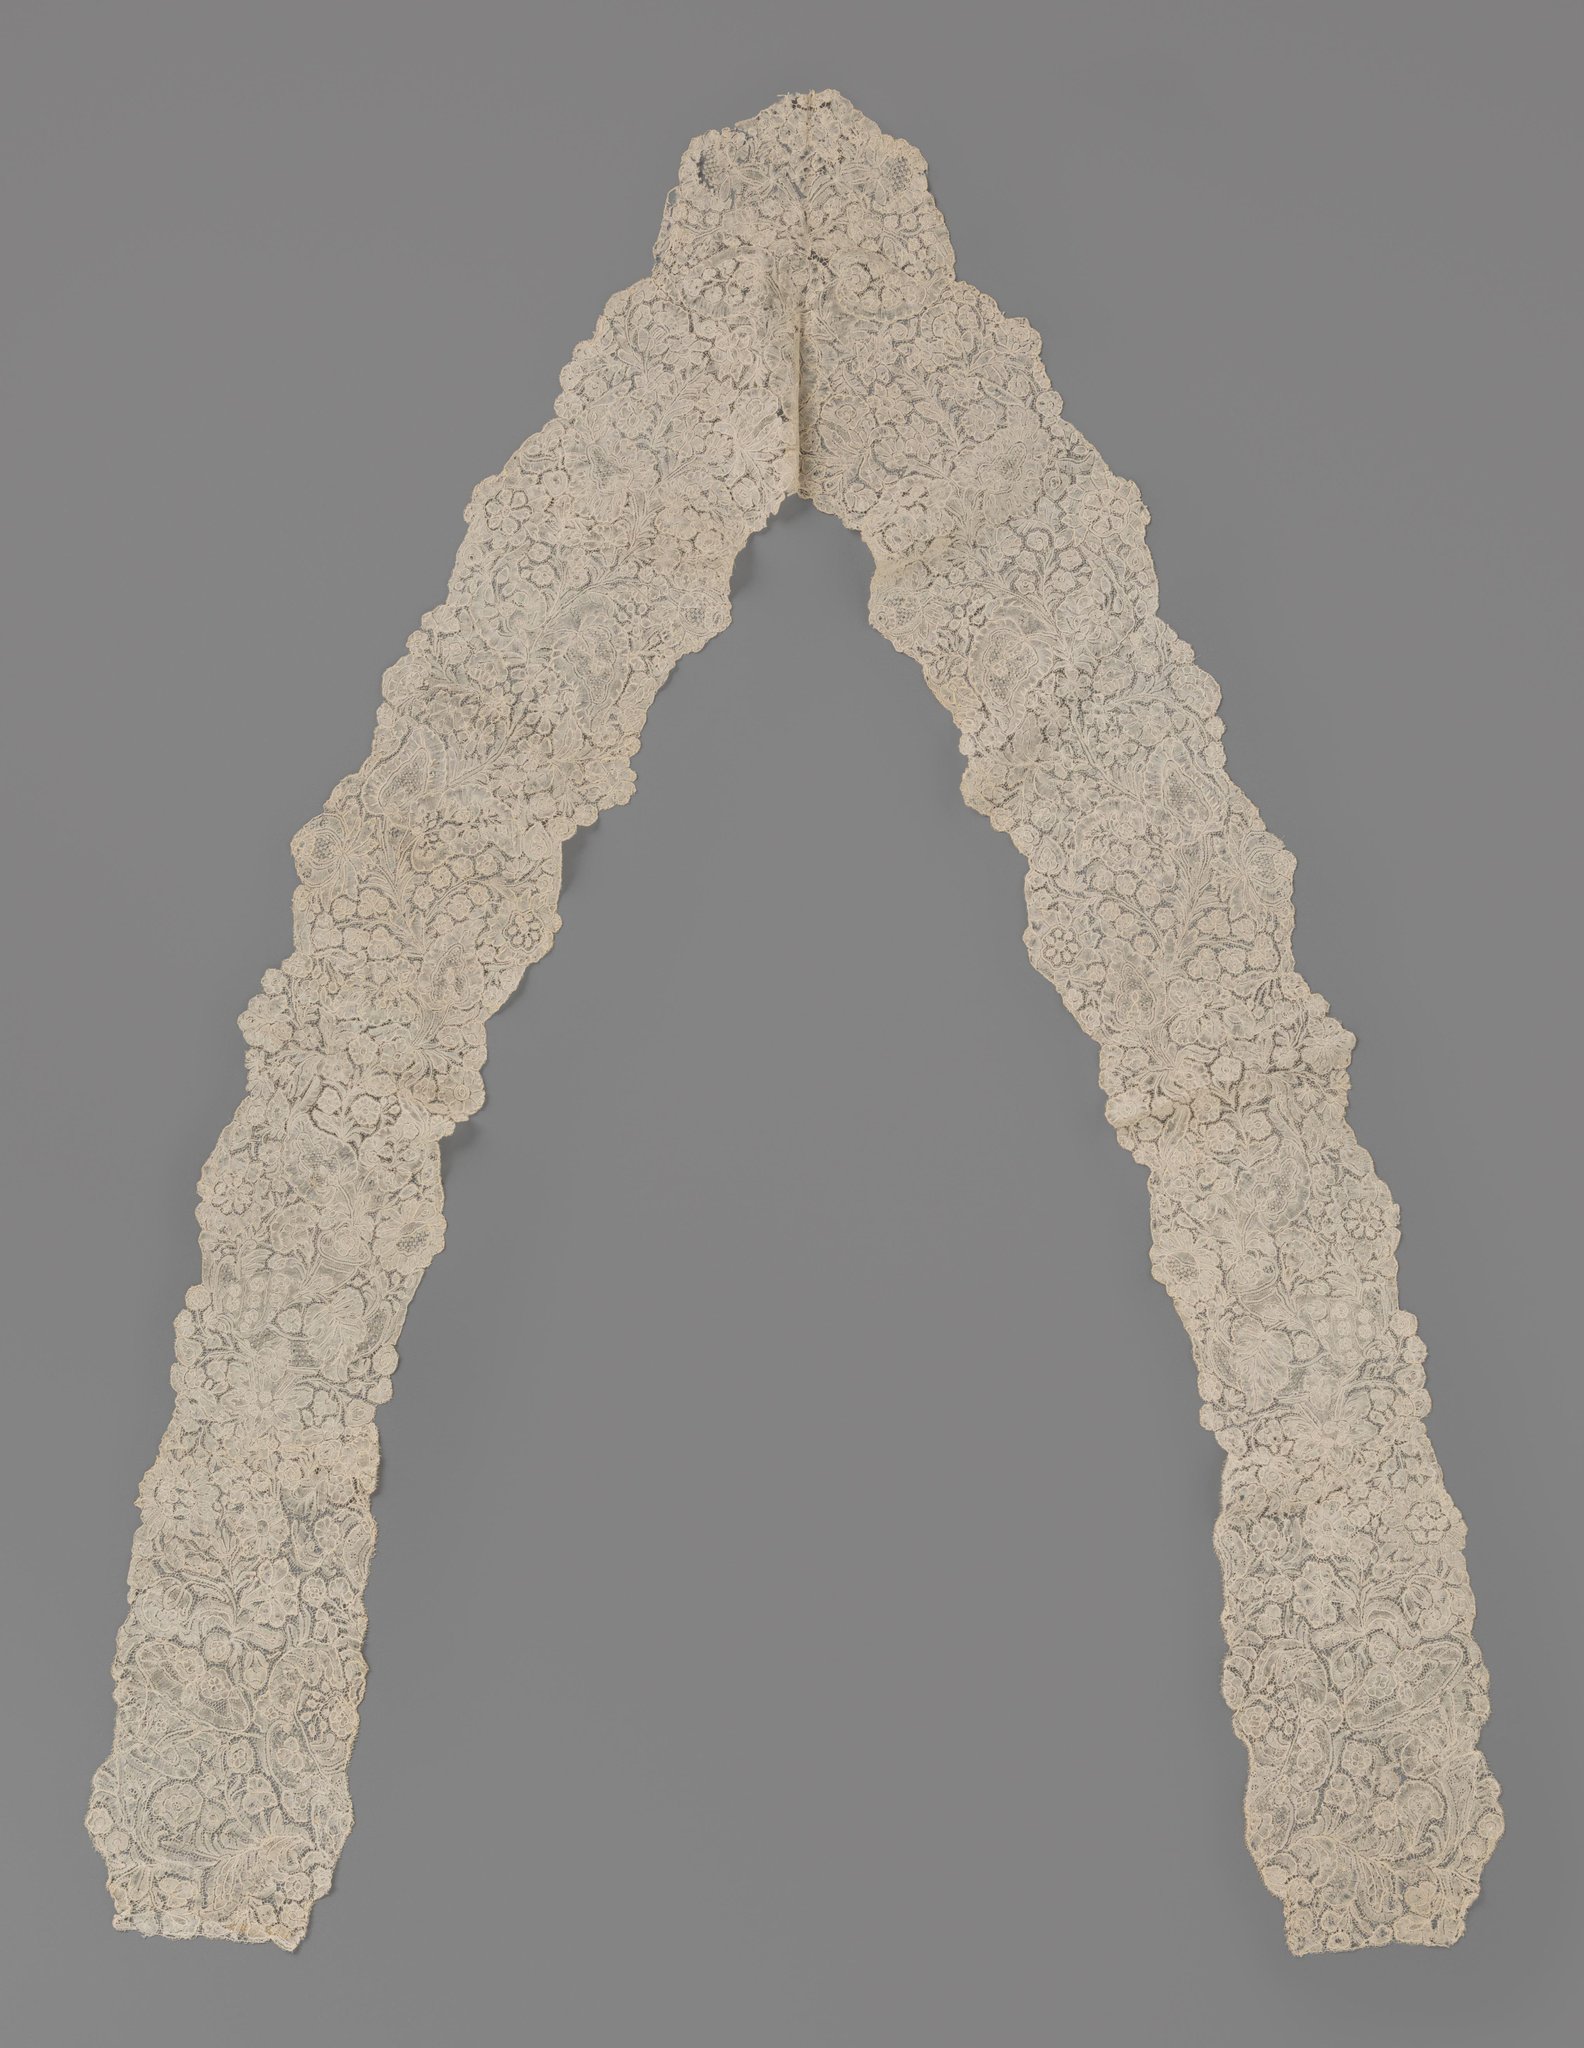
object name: commode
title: Fontange bestaande uit twee aan elkaar genaaide mutsenslippen, Brusselse kloskant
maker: Anonymous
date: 1720-1730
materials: lace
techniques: lace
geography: western europe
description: Fontange van Brusselse kant, bestaande uit twee aan elkaar genaaide mutsenslippen. Het kant heeft een patroon van bloemen en bladeren.